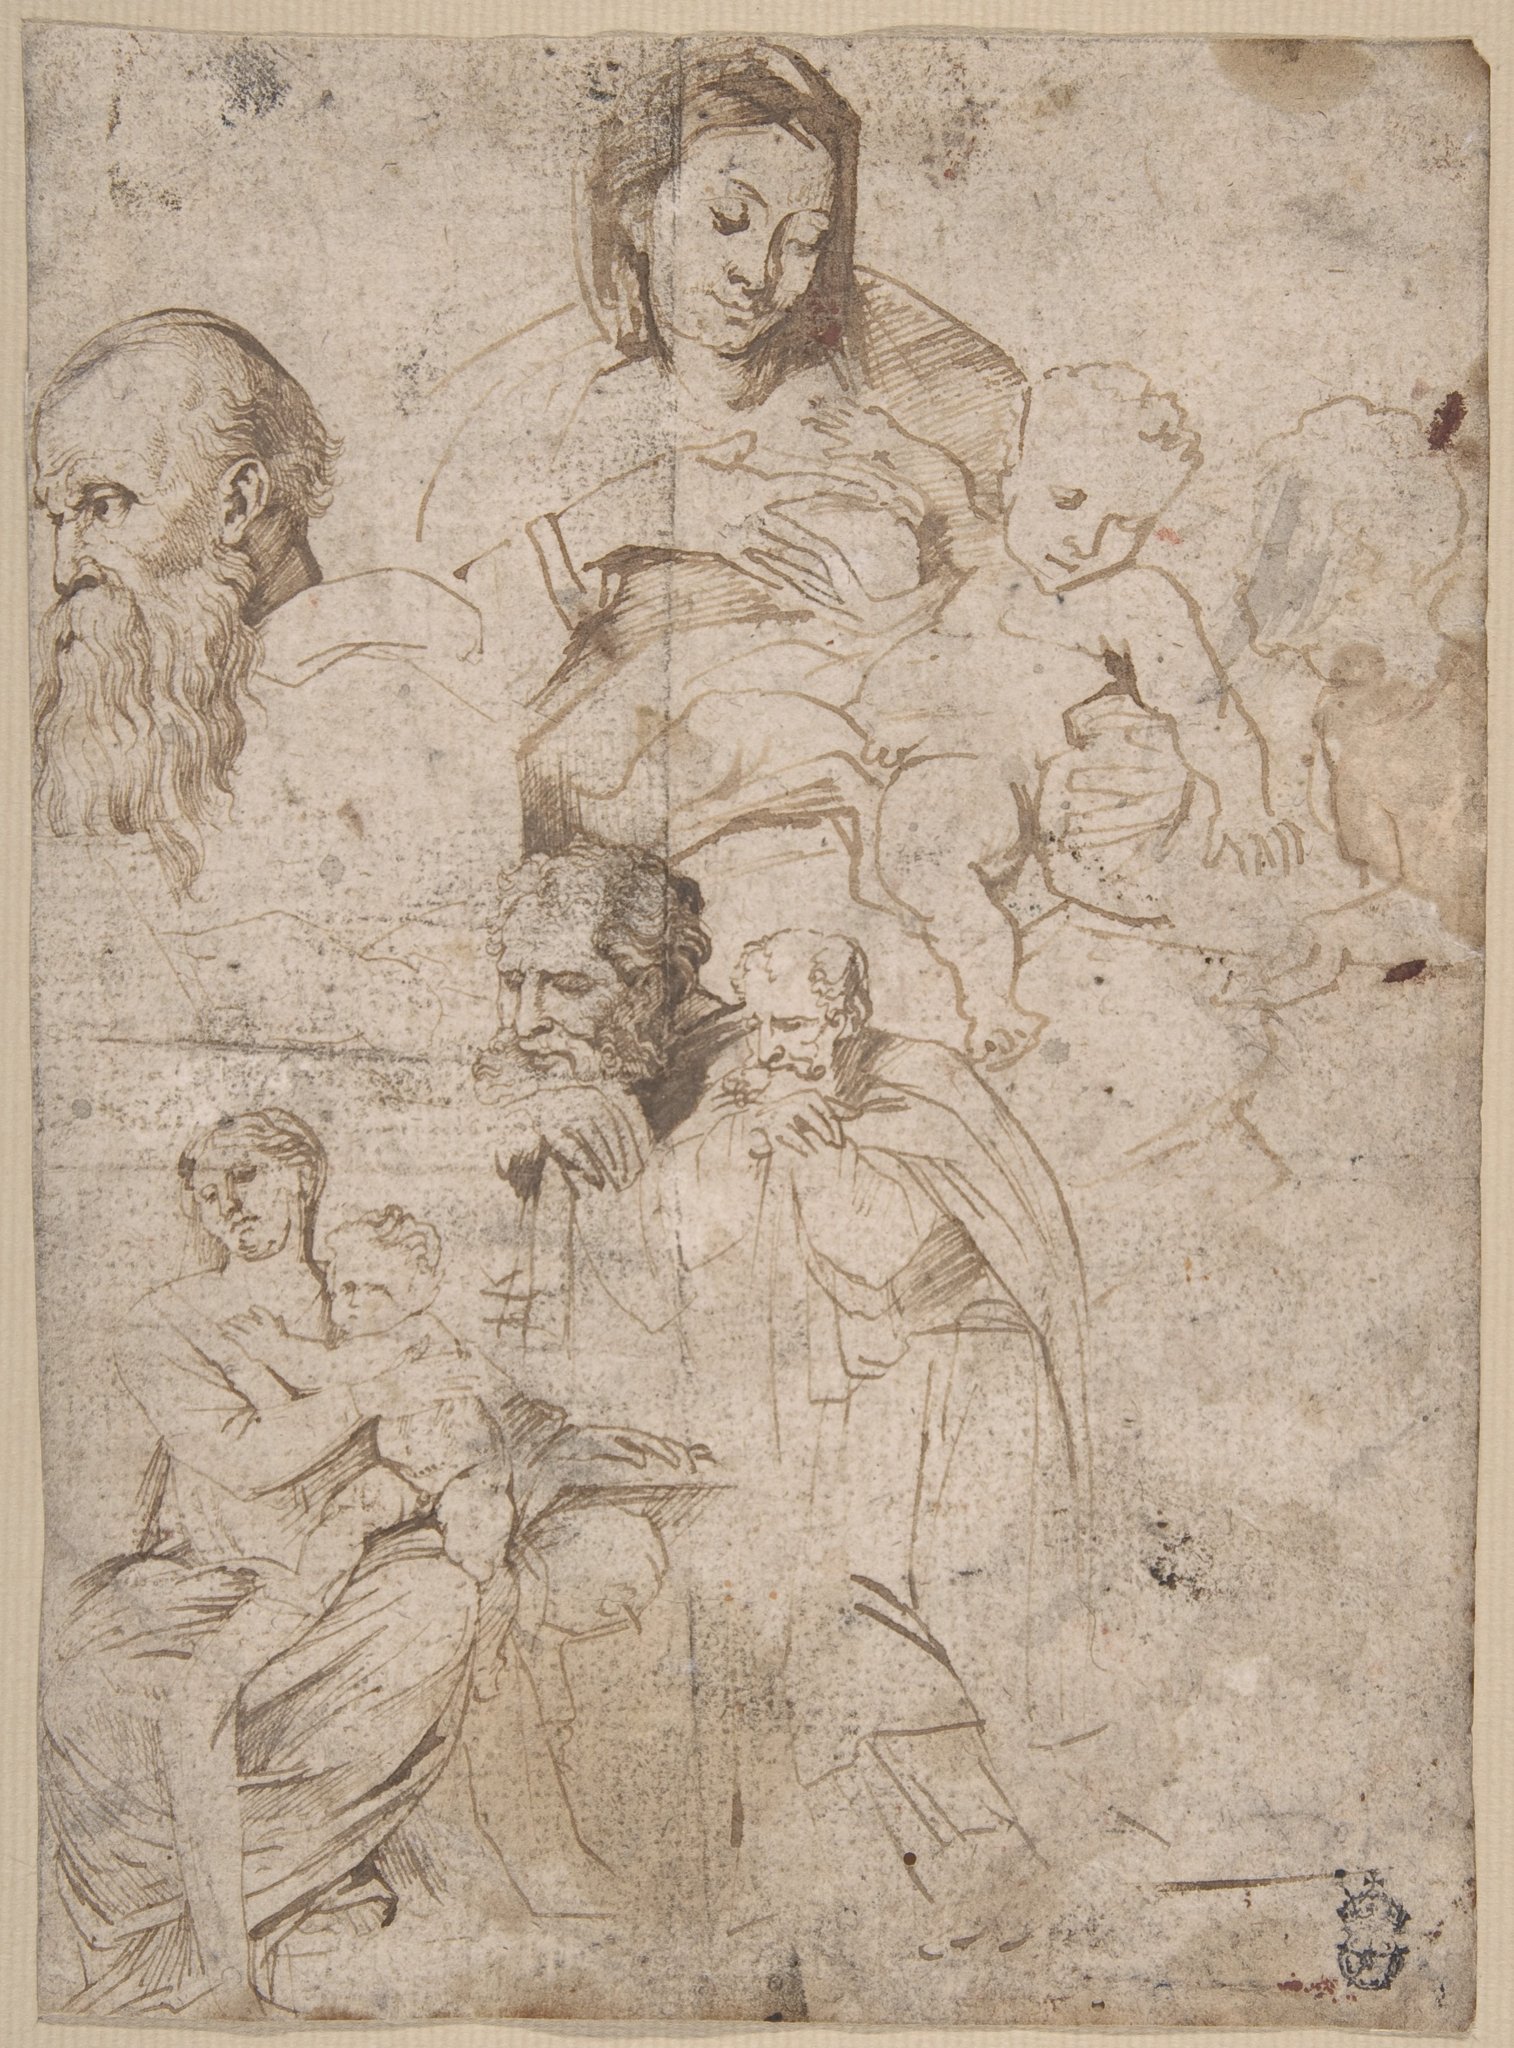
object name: drawing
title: Sheet of Studies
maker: anthony van dyck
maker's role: artist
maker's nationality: flemish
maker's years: 1599-1641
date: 1621-1627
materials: ink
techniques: brush, pen, wash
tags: infants,men,women